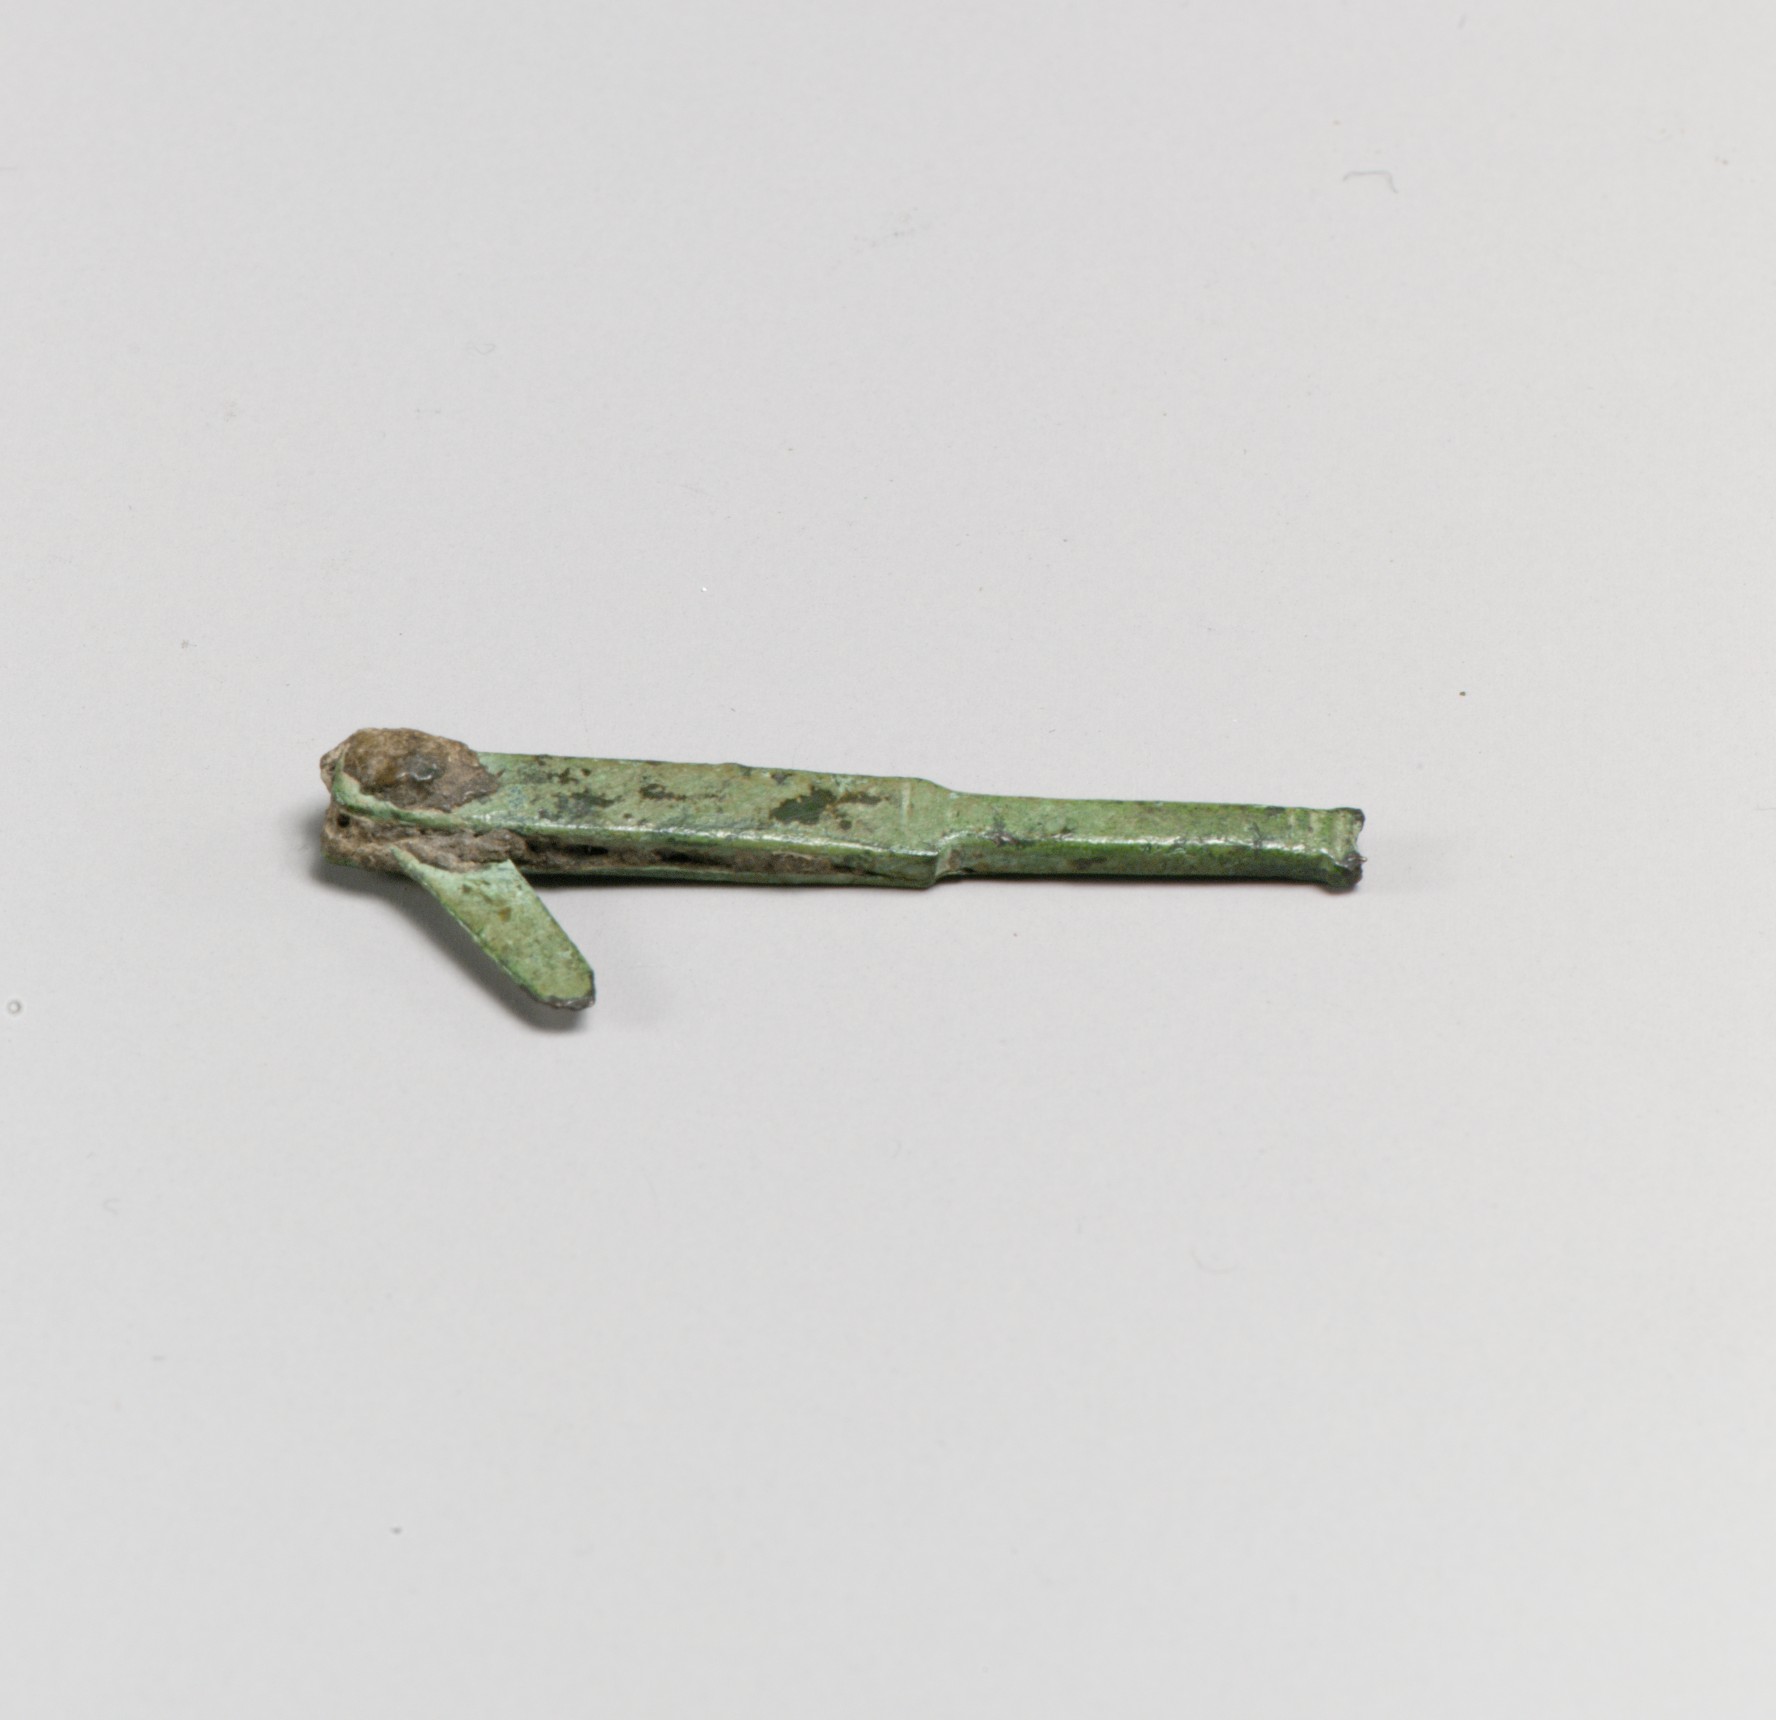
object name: knife or lancet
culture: etruscan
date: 900-100 BCE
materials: bronze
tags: knives